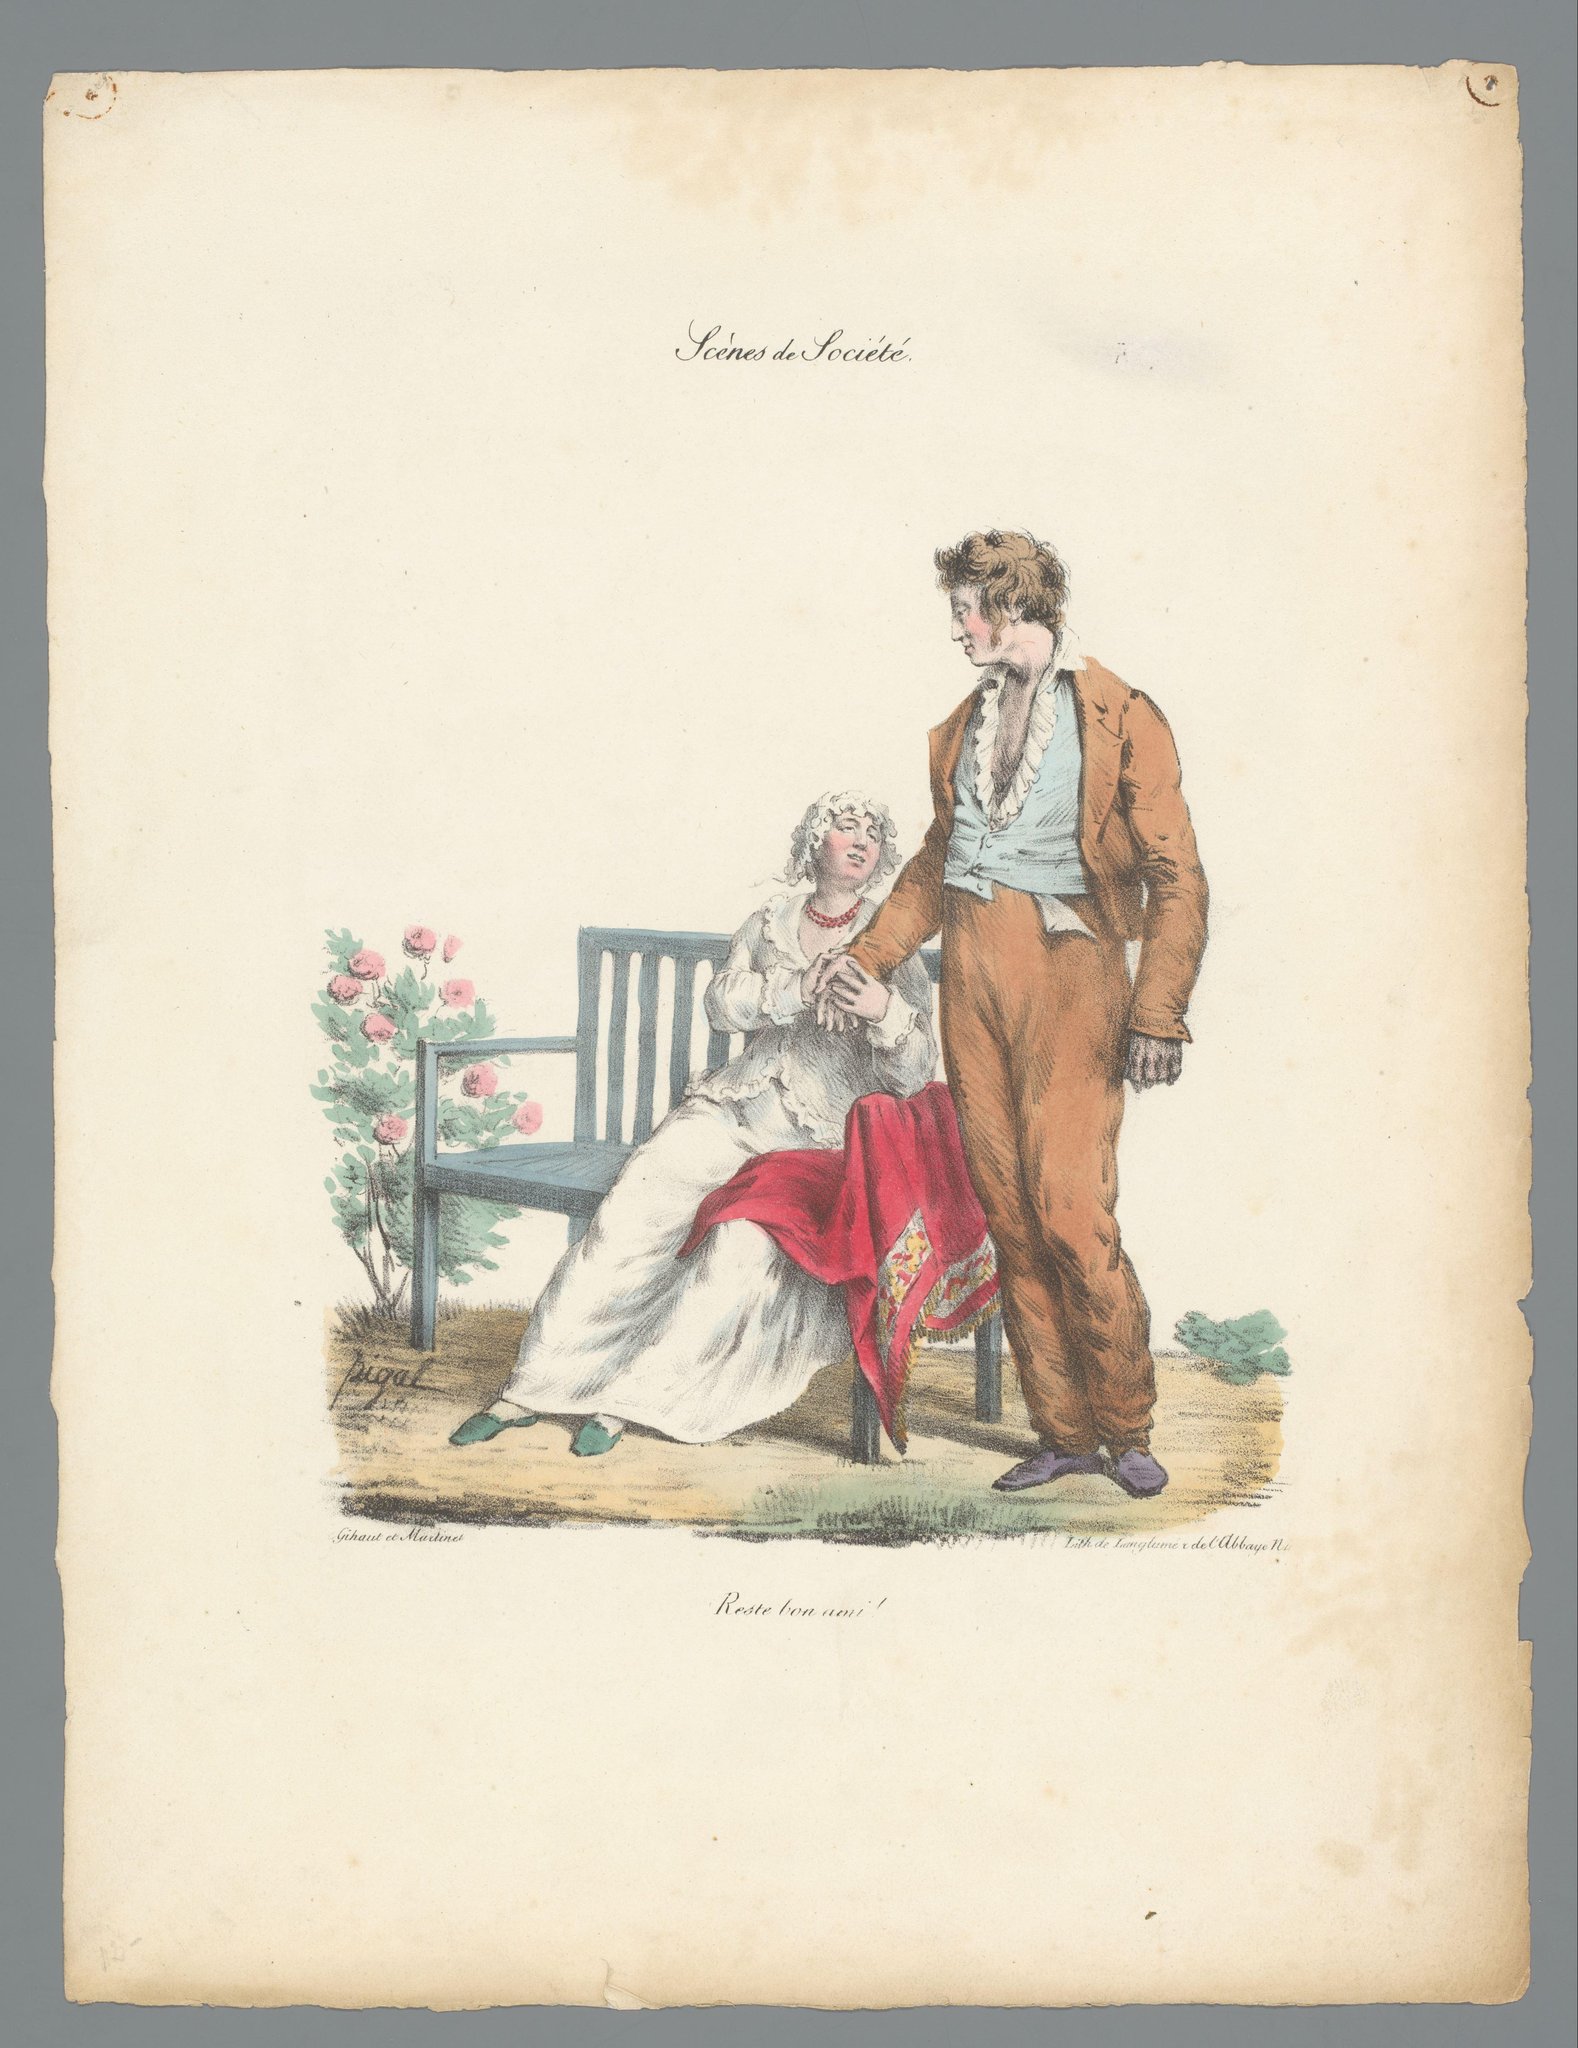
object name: print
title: Reste bon ami!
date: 1822-1824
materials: paper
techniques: hand coloring, lithograph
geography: paris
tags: adolescent, young woman, maiden, youth, adolescent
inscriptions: collector's mark: Lugt 2228